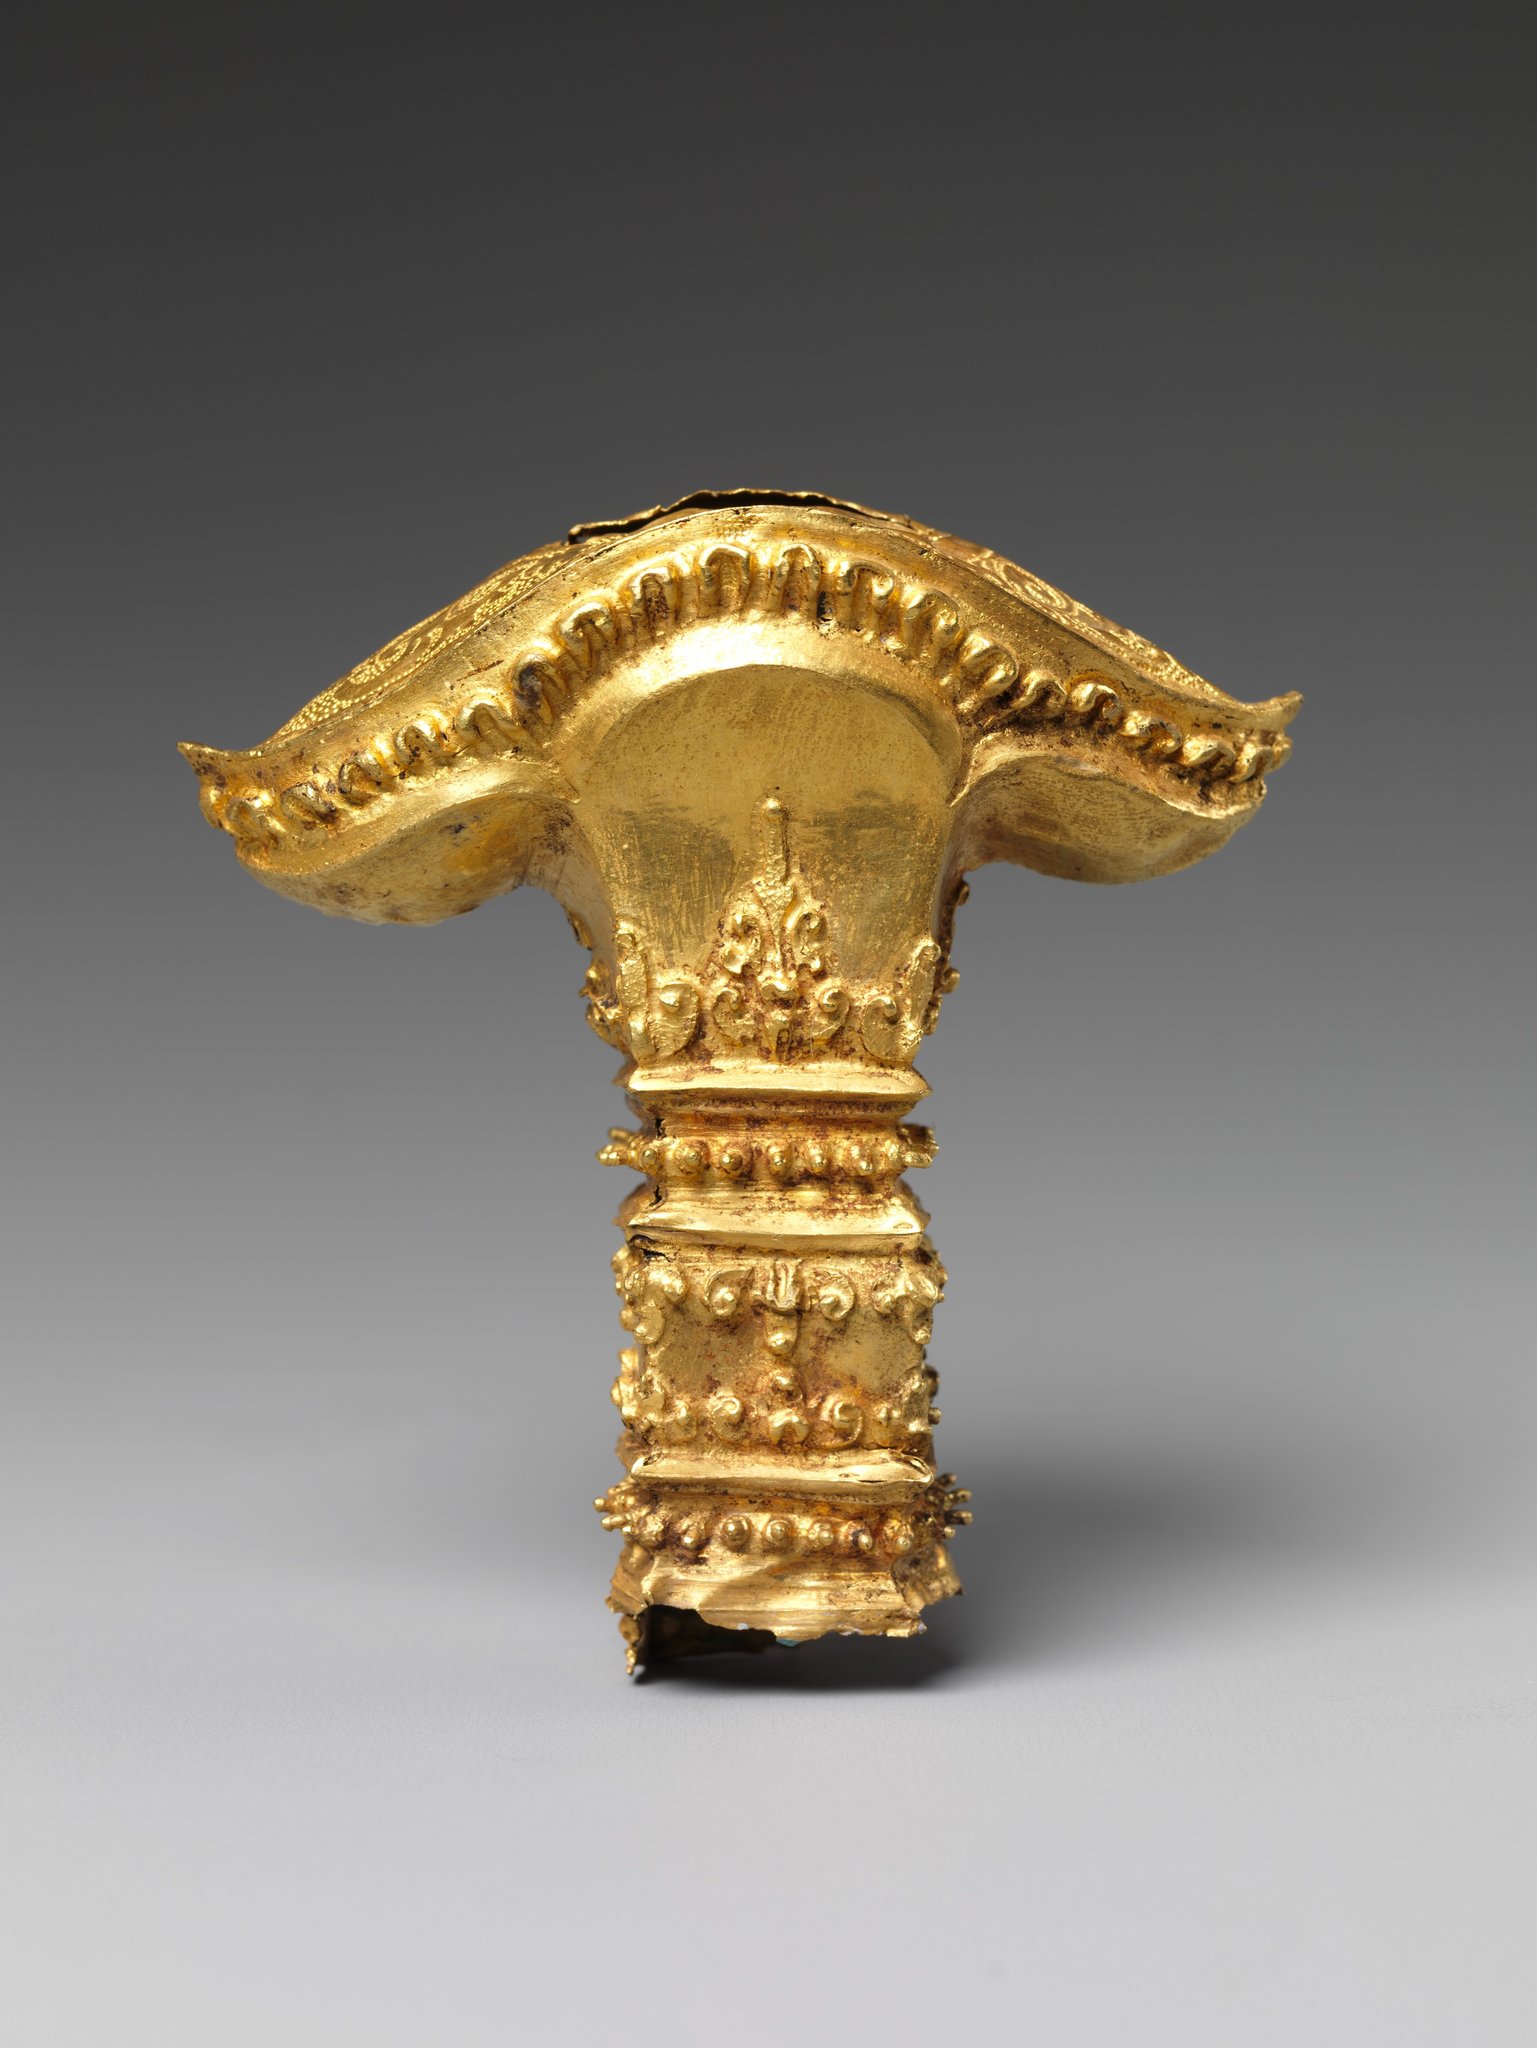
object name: hilt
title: Hilt of a Weapon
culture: indonesian, javanese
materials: gold